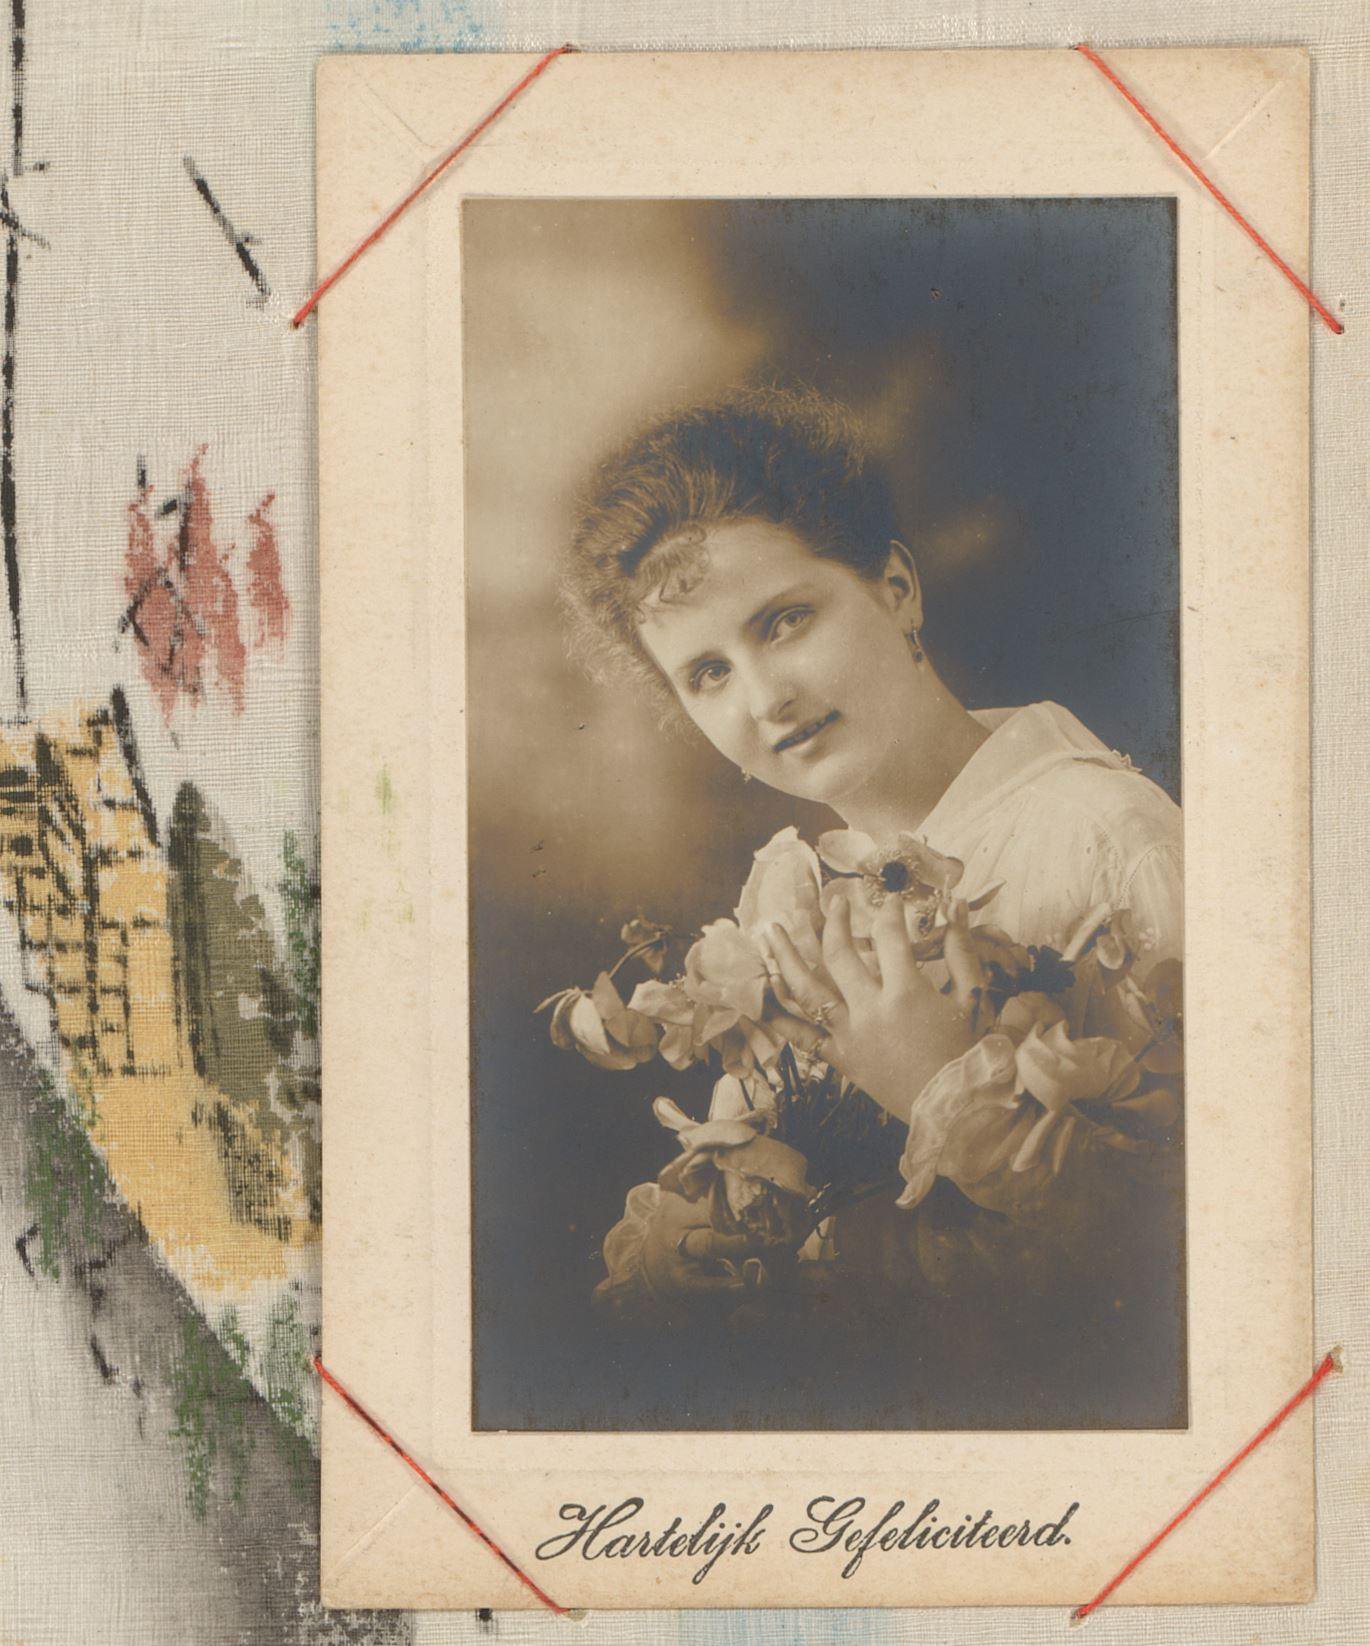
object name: ansichtkaart, prentbriefkaart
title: Hartelijk Gefeliciteerd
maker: Anonymous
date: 1880-1920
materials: paint, photographic support, silk, textile, watercolor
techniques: brush, gelatin silver print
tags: flowers, adult woman, historical persons